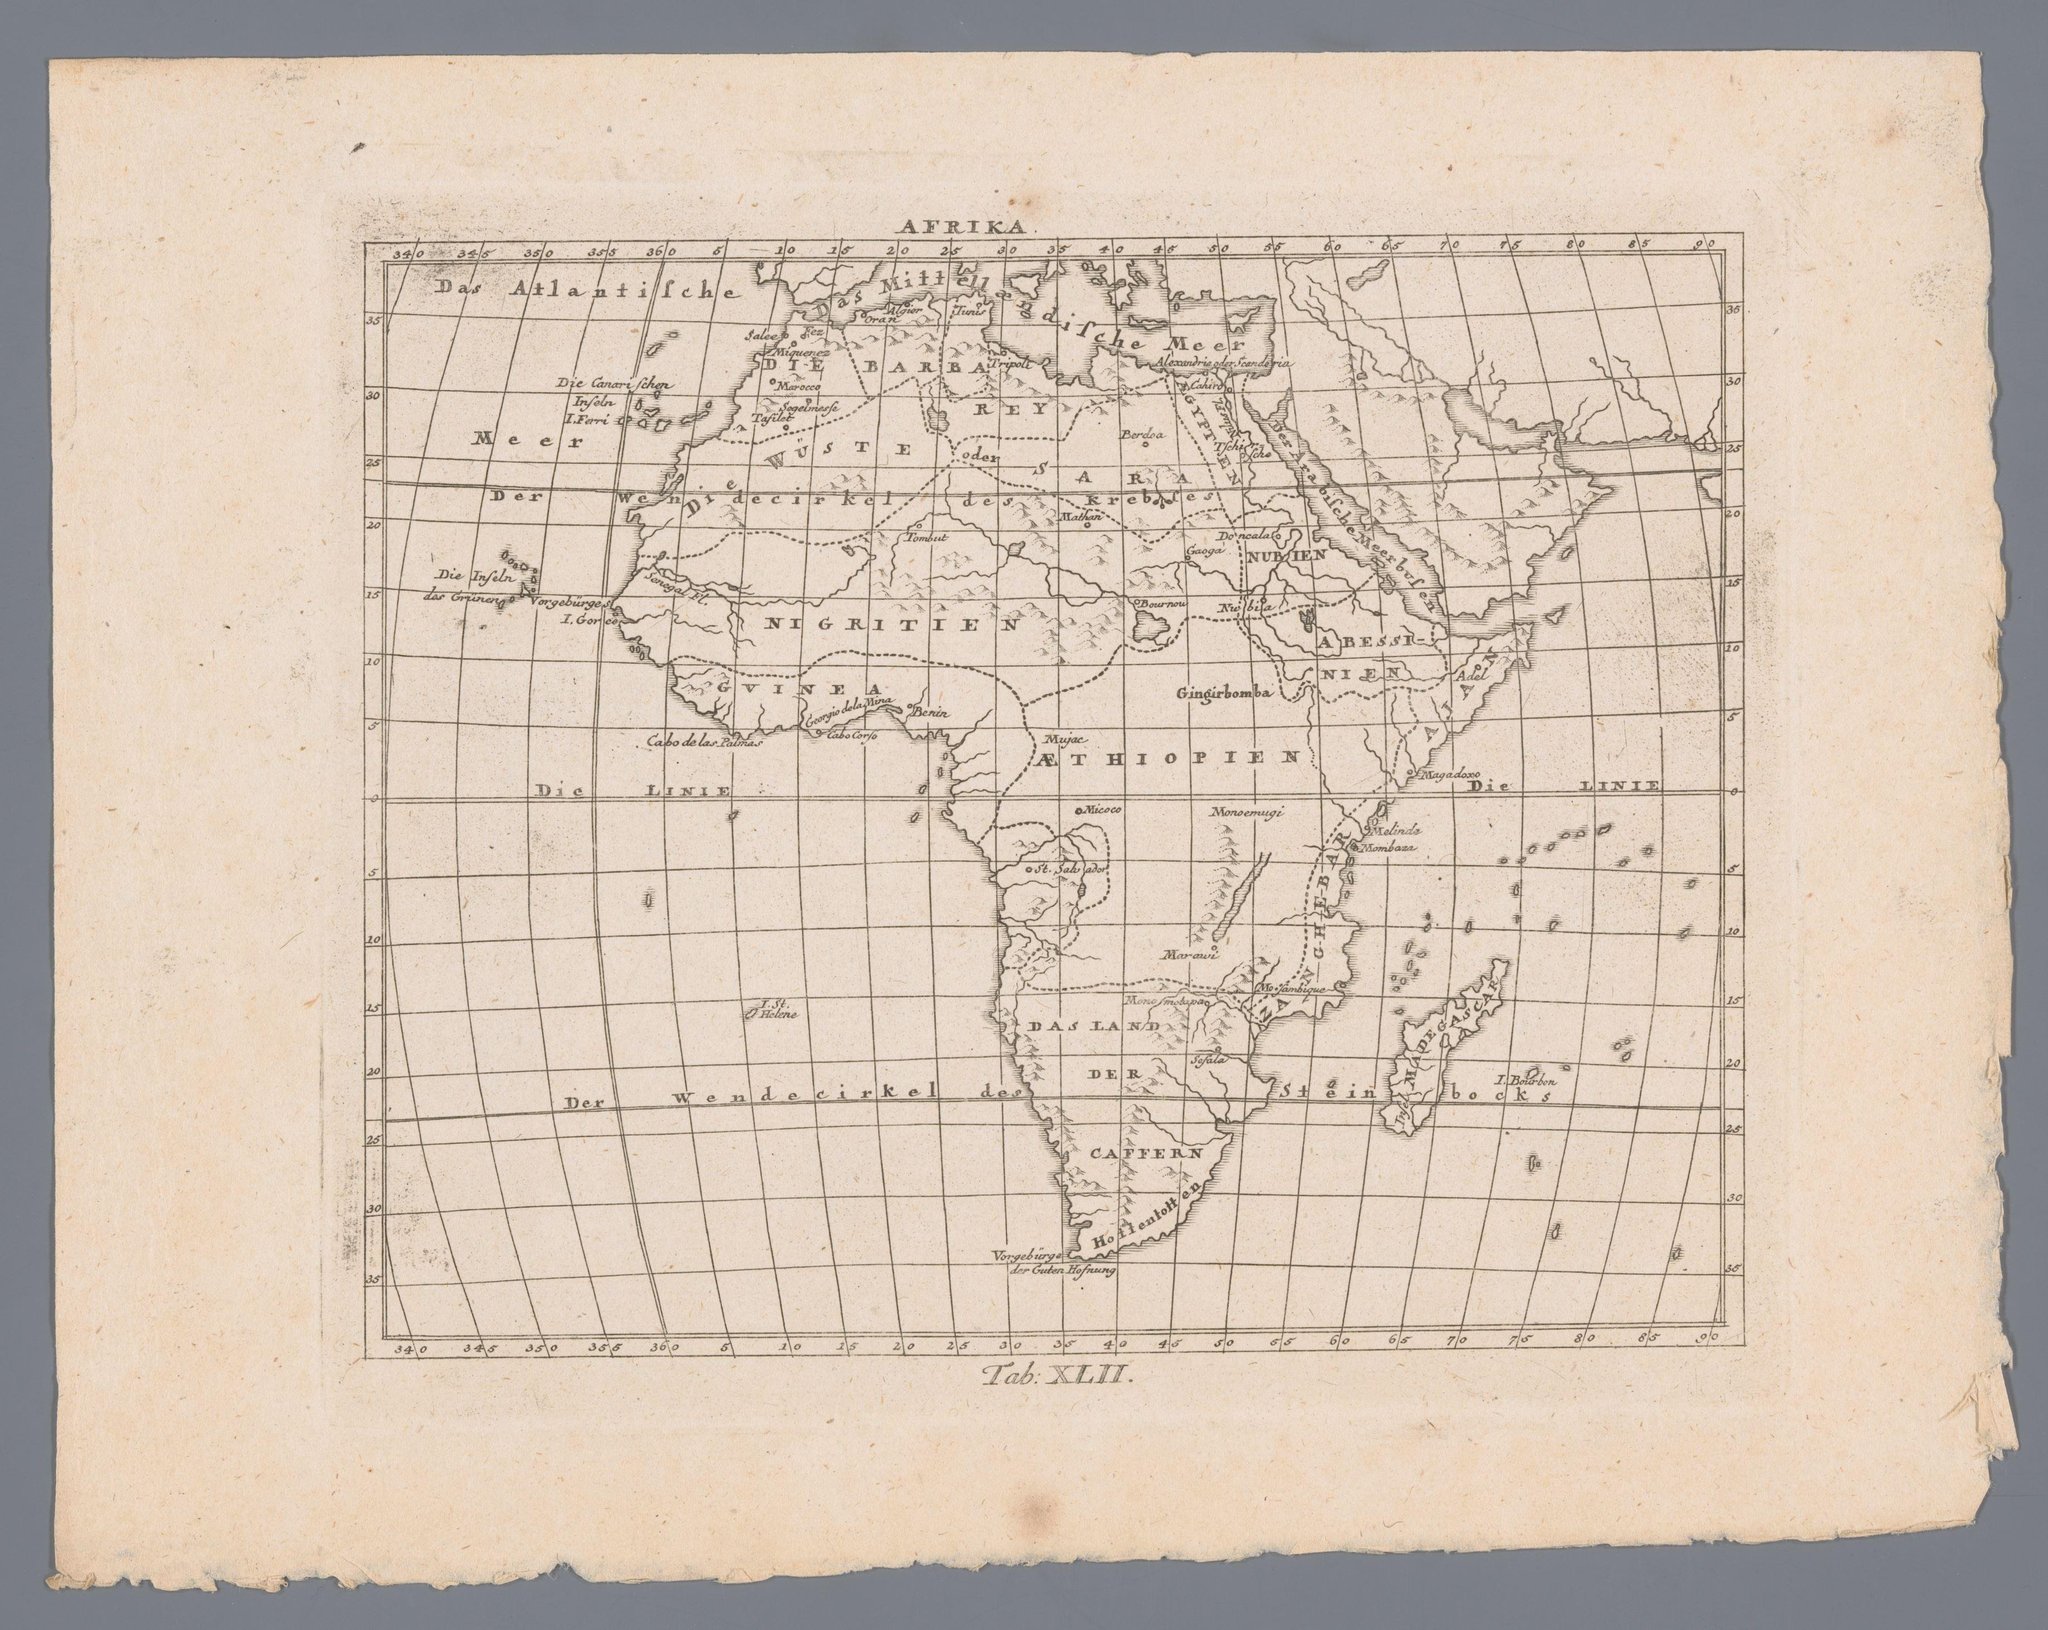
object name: print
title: Kaart van Afrika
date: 1774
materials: paper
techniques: etching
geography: germany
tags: (map of) africa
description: Prent ook gebruikt in: Basedow, Johann Bernhard. Das Basedowische Elementarwerk. Ein Vorrath der besten Erkenntnisse zum Lernen, Lehren, Wiederholen und Nachdenken. Leipzig: Siegfried Lebrecht Crucius, 1774.